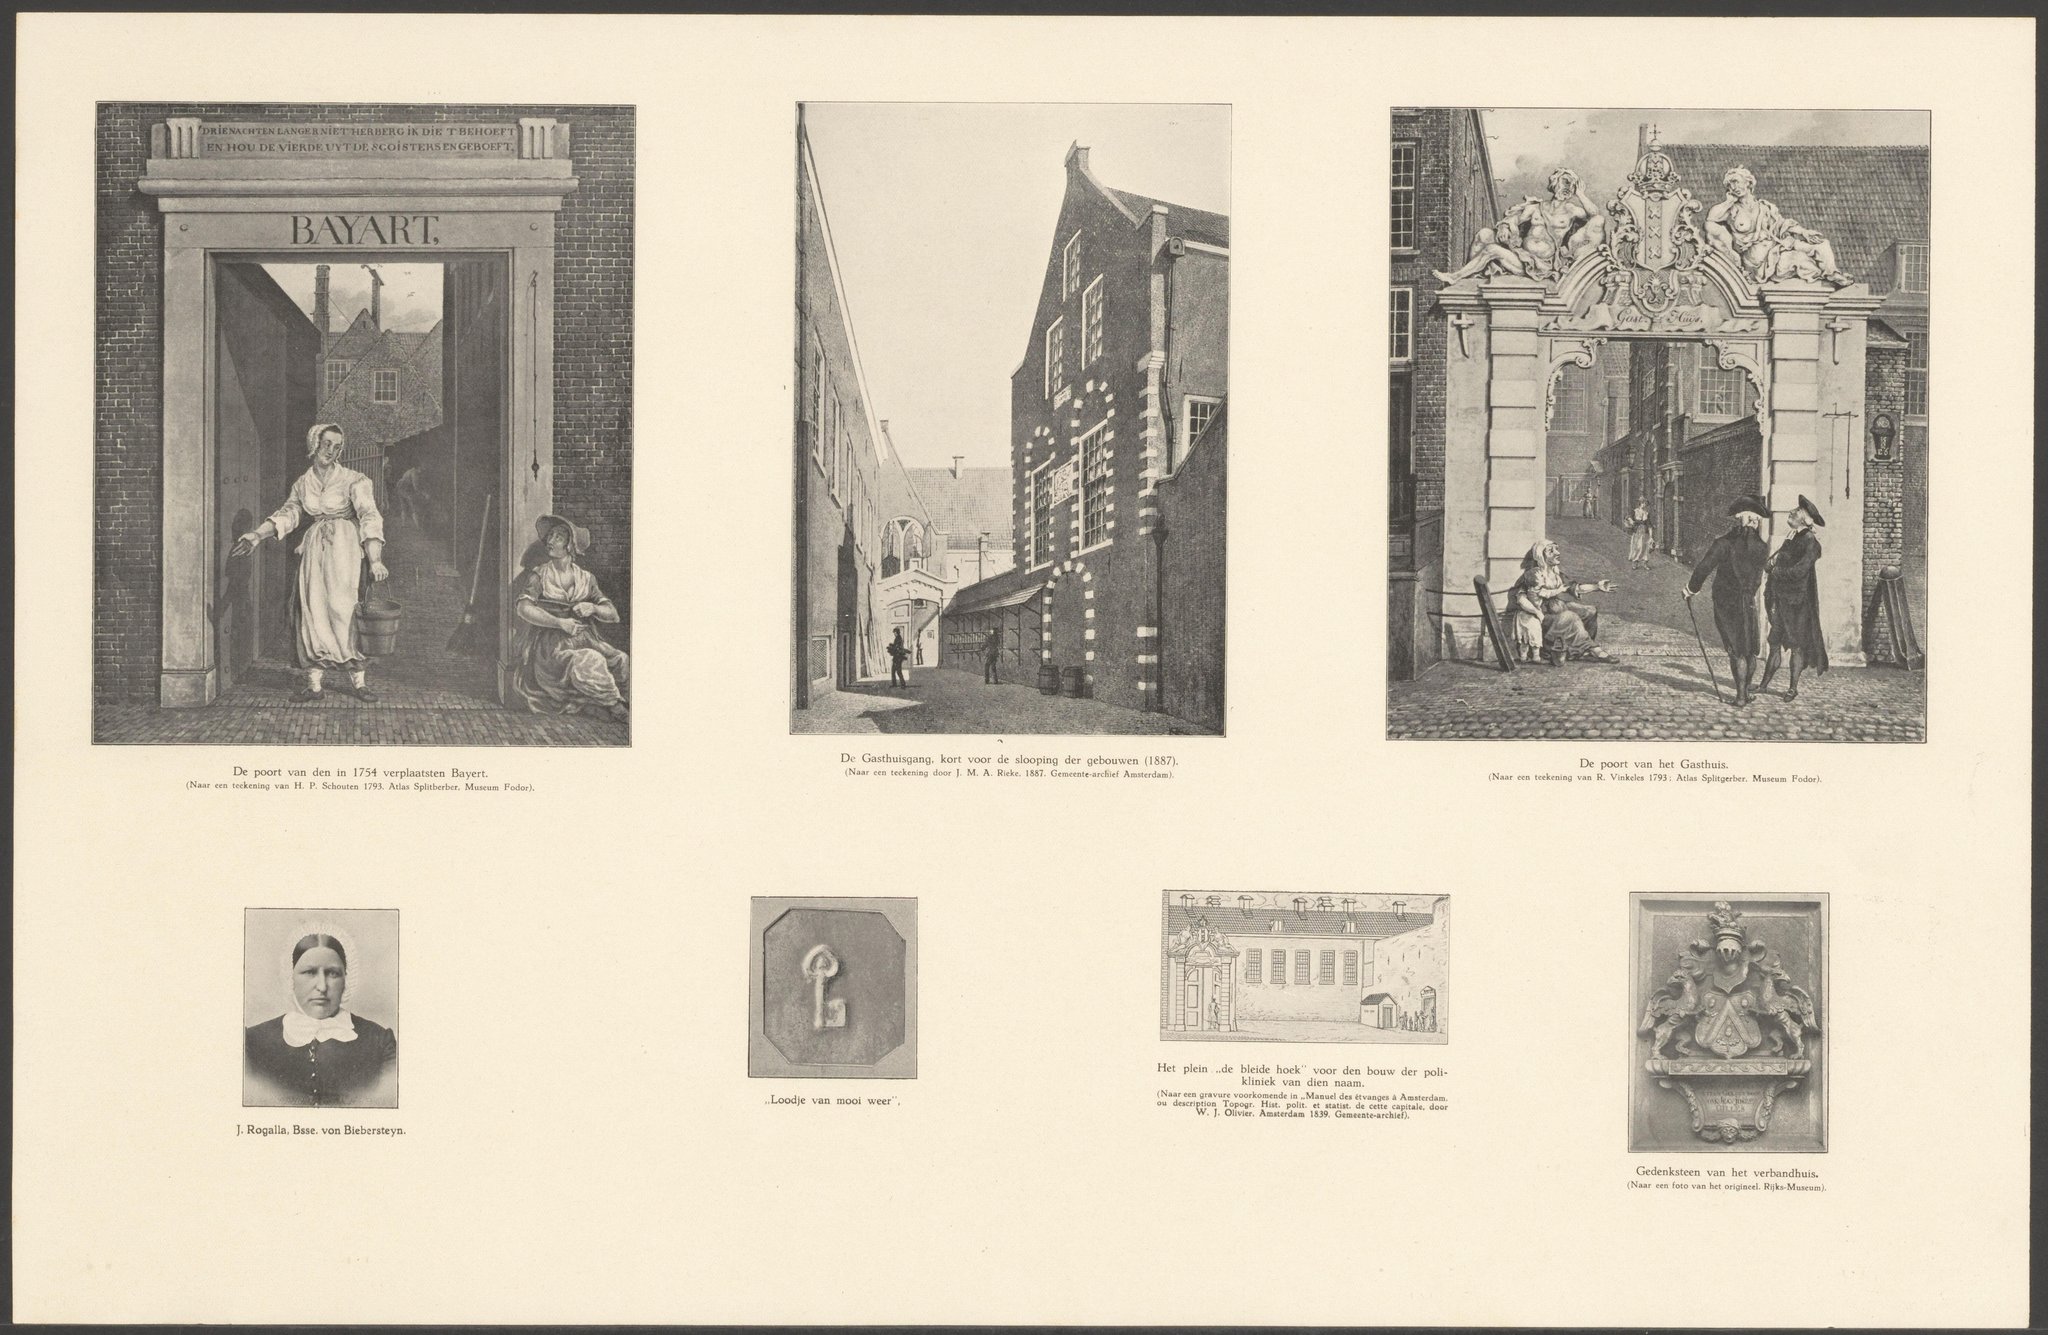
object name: photomechanical print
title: Voorstellingen rond het Binnengasthuis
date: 1912-1970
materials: paper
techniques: letterpress printing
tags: historical persons, hospital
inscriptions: collector's mark: Lugt 1641b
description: Zeven losse voorstellingen over het Binnengasthuis, met poort van de Bayert, de Gasthuisgang en poort van het Gasthuis. Onderwerpsrubriek binnen de Atlas Amsterdam: Armwezen en liefdadige instellingen: I. Stadsinrichtingen: Binnengasthuis.